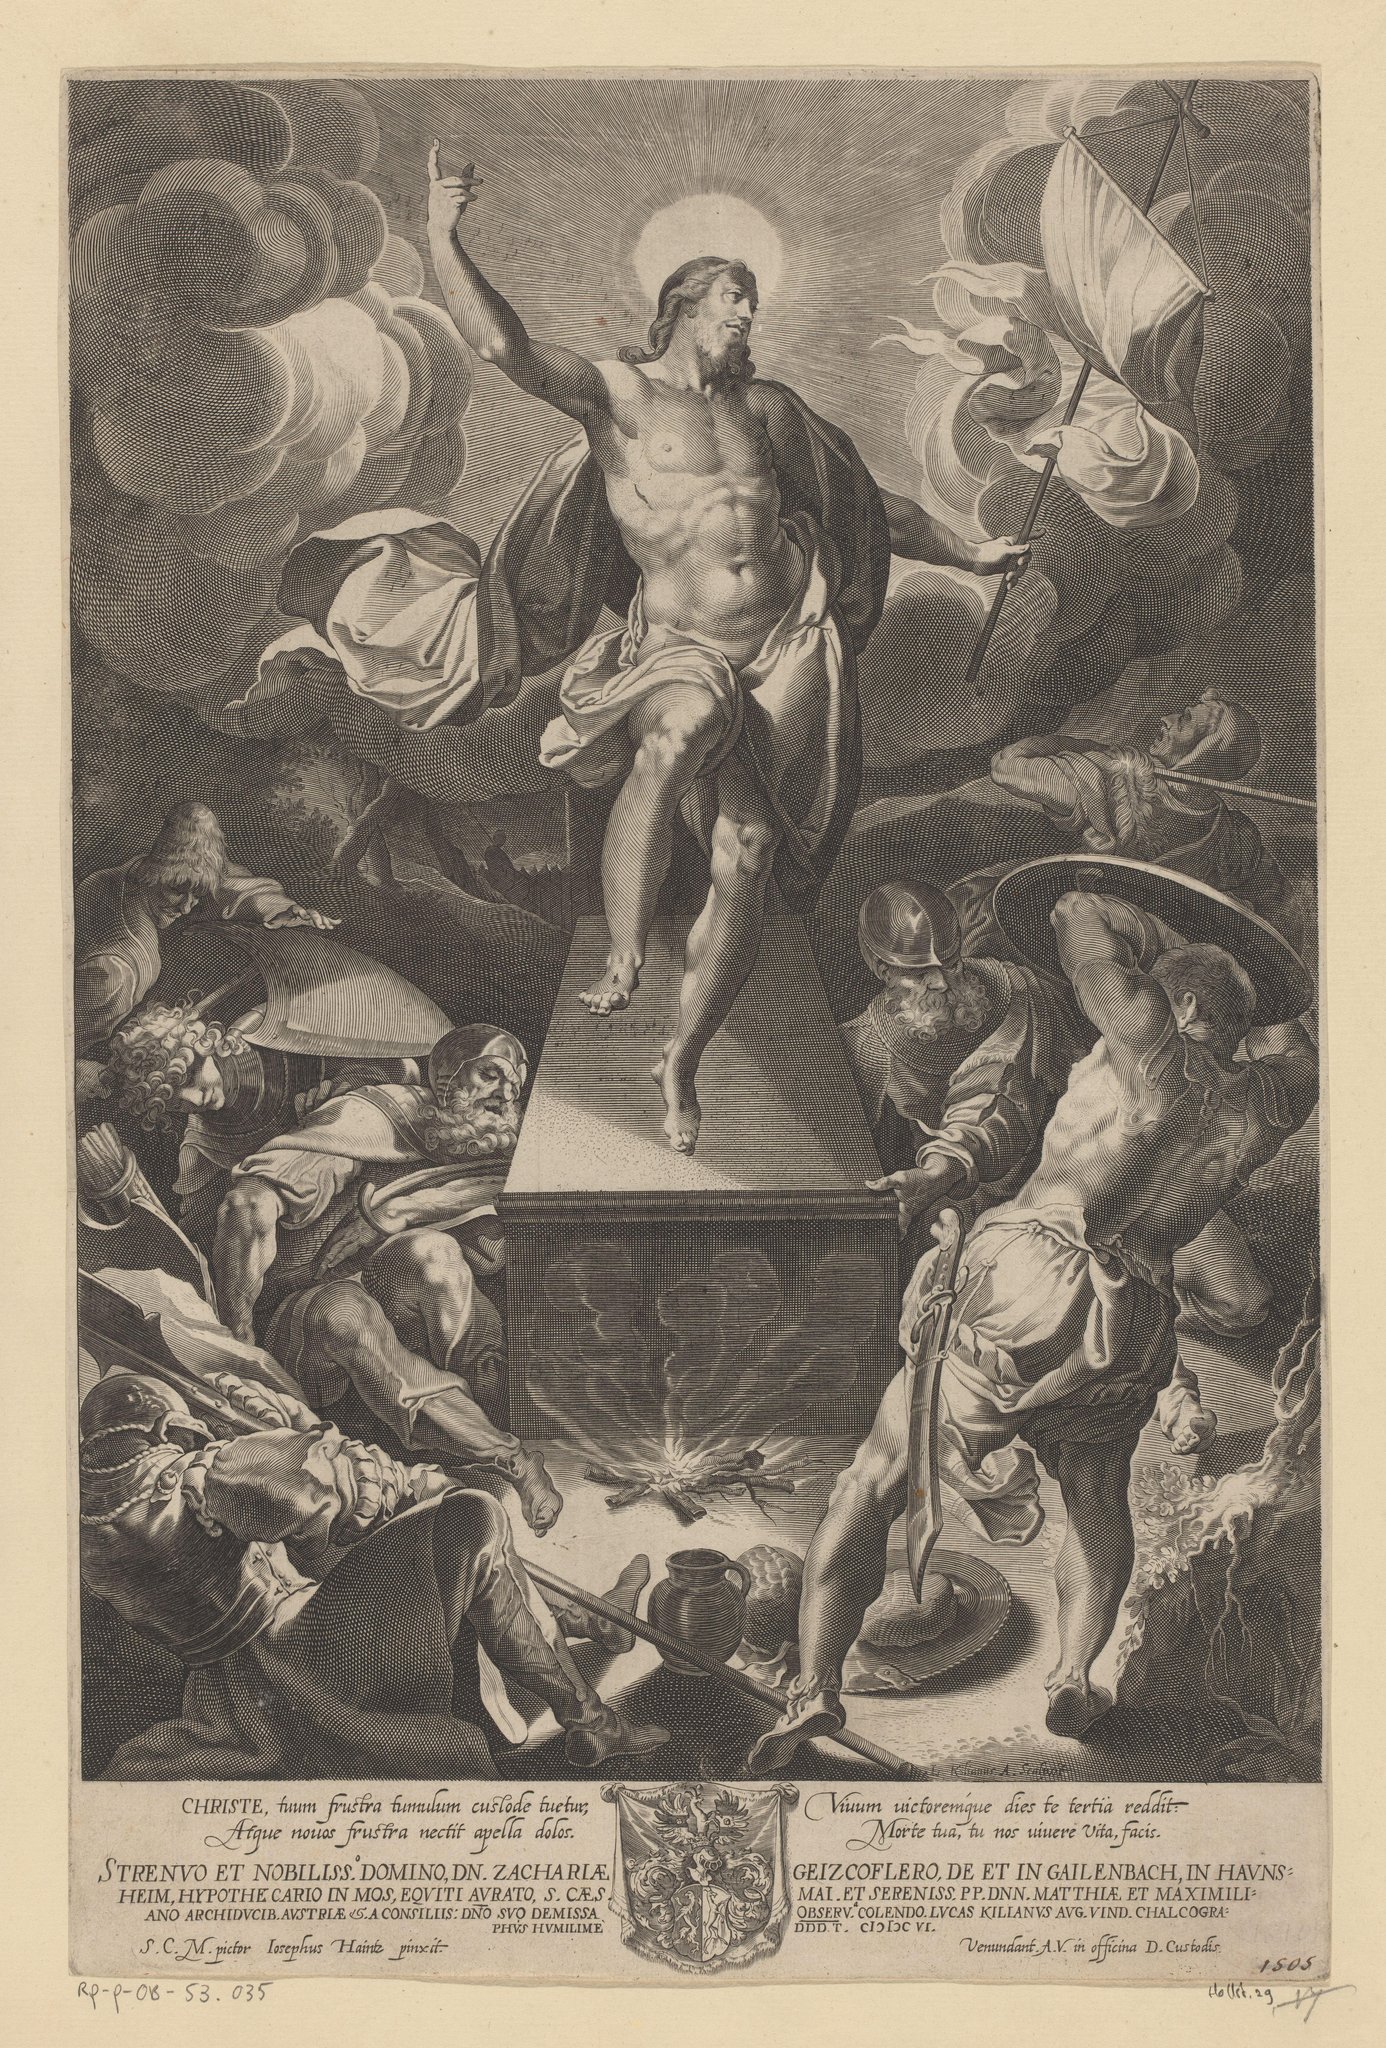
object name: print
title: Opstanding van Christus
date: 1606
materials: paper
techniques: engraving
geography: augsburg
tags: christ, usually holding a banner, arises from the grave; often combined with sleeping and/or frightened soldiers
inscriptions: collector's mark: Lugt 240